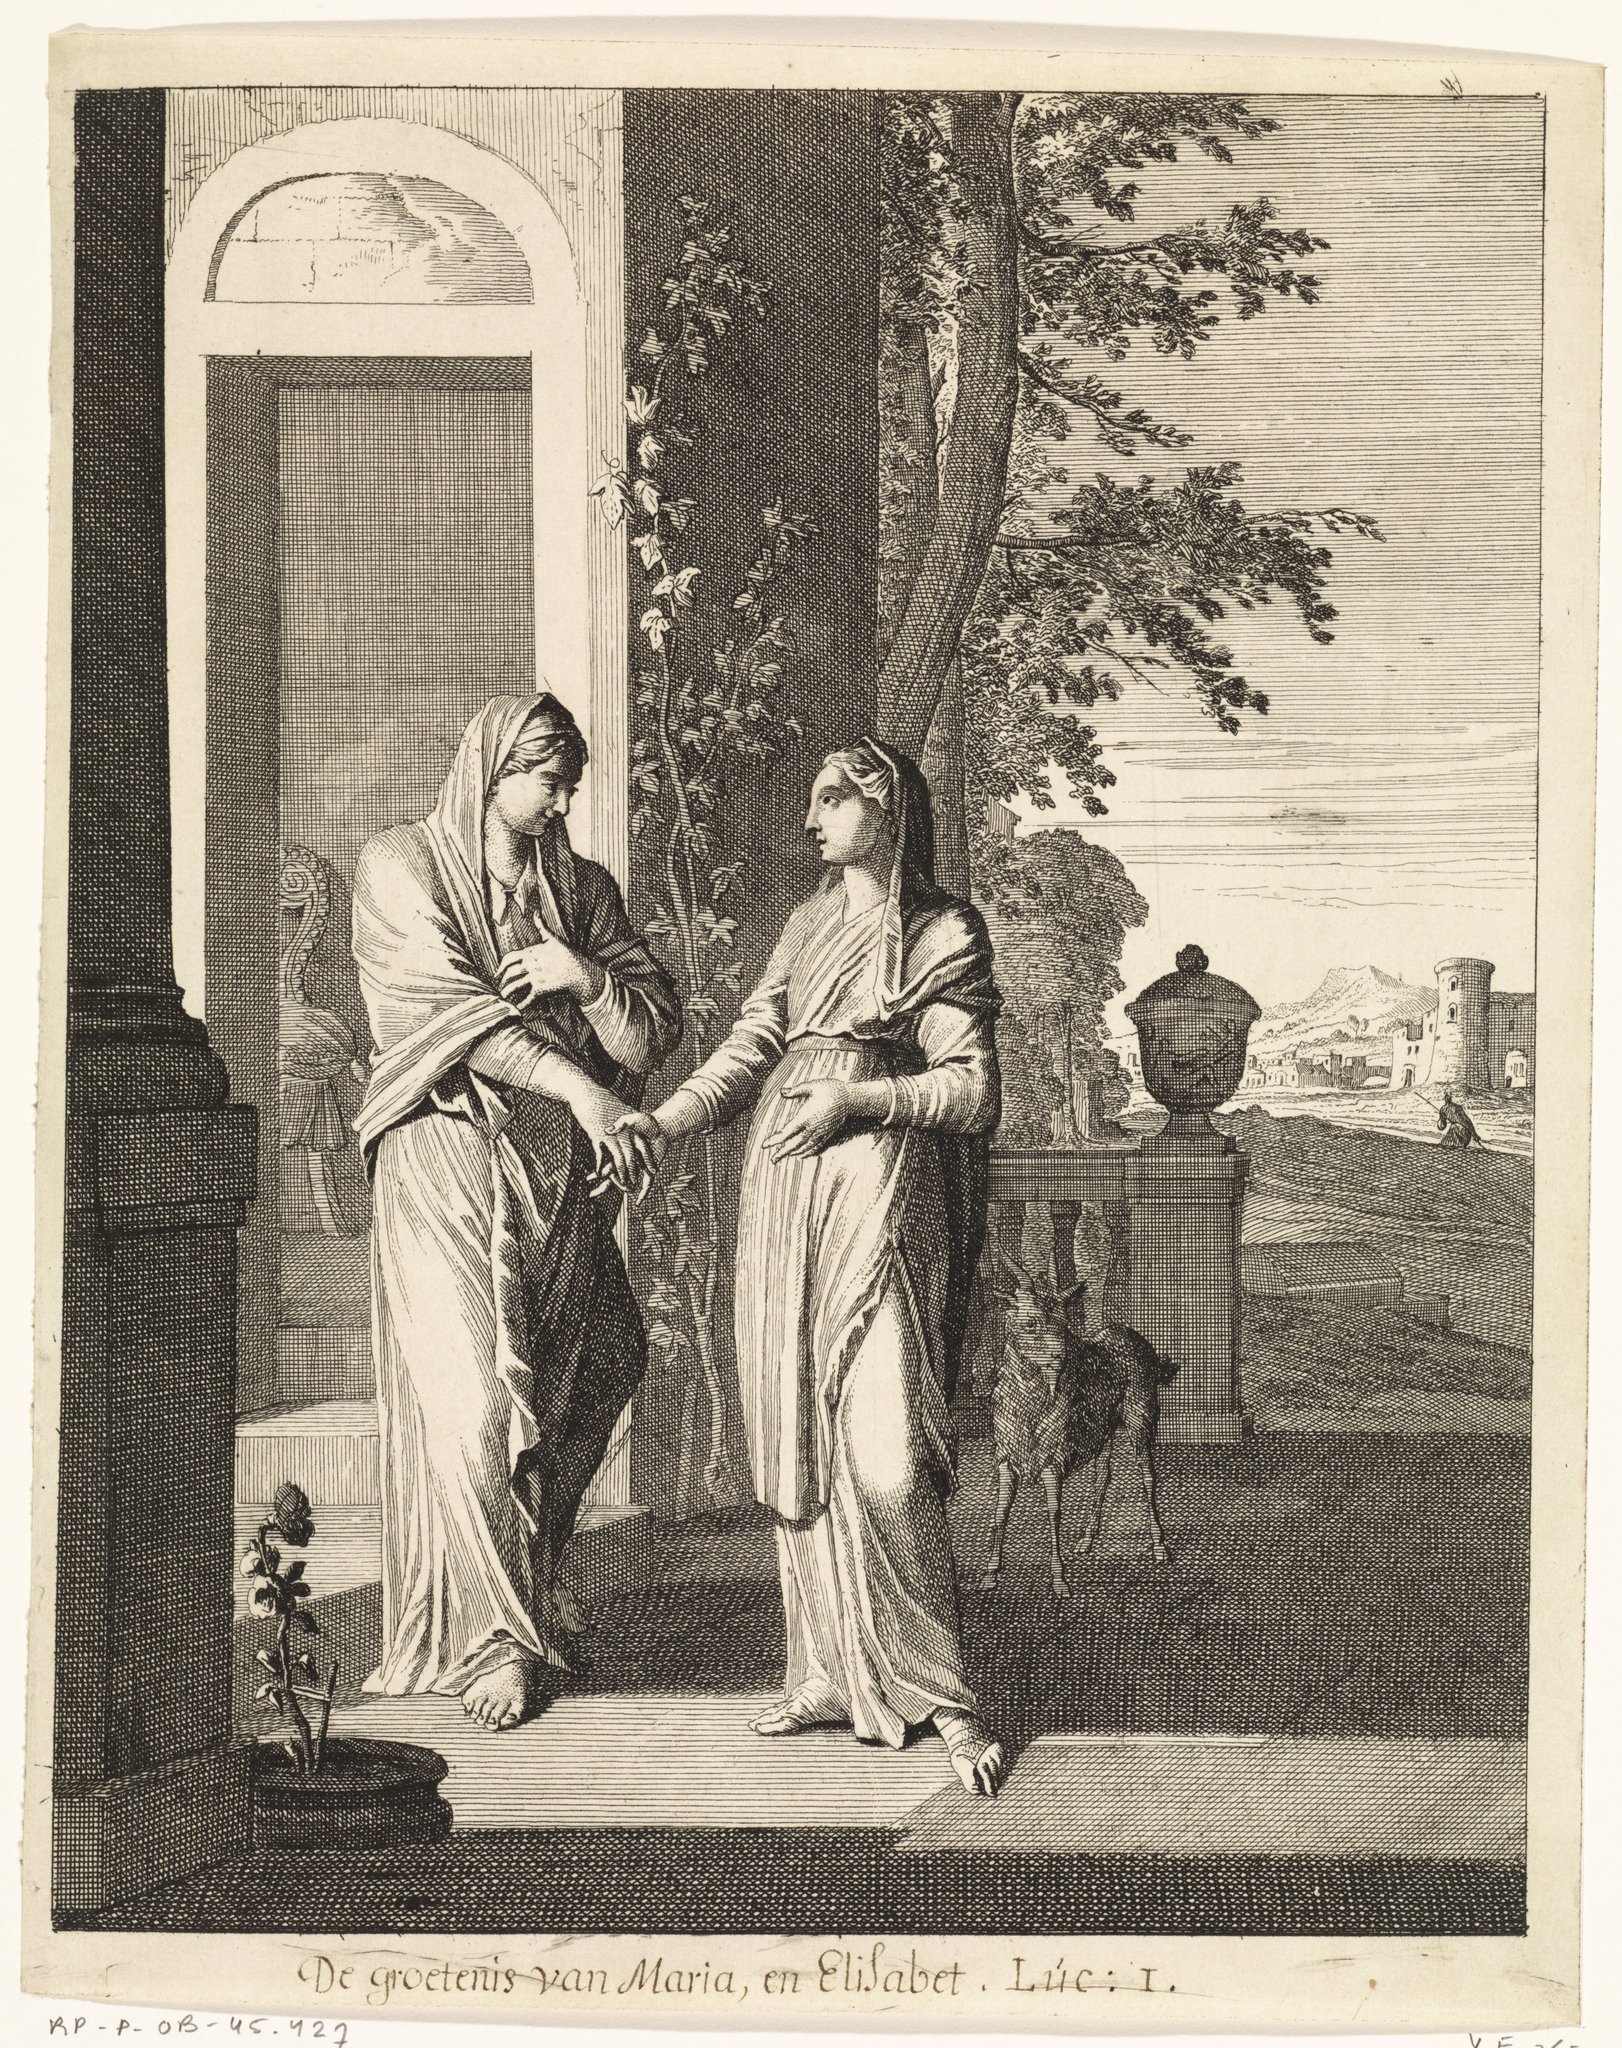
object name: print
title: Visitatie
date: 1708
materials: paper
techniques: etching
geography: nuremberg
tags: mary and elisabeth shaking hands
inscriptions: collector's mark: Lugt 2228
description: Proefdruk van een prent welke is opgenomen als illustratie in: Historiae Celebriores Veteris Testamenti. Christoph Weigel, 1708.